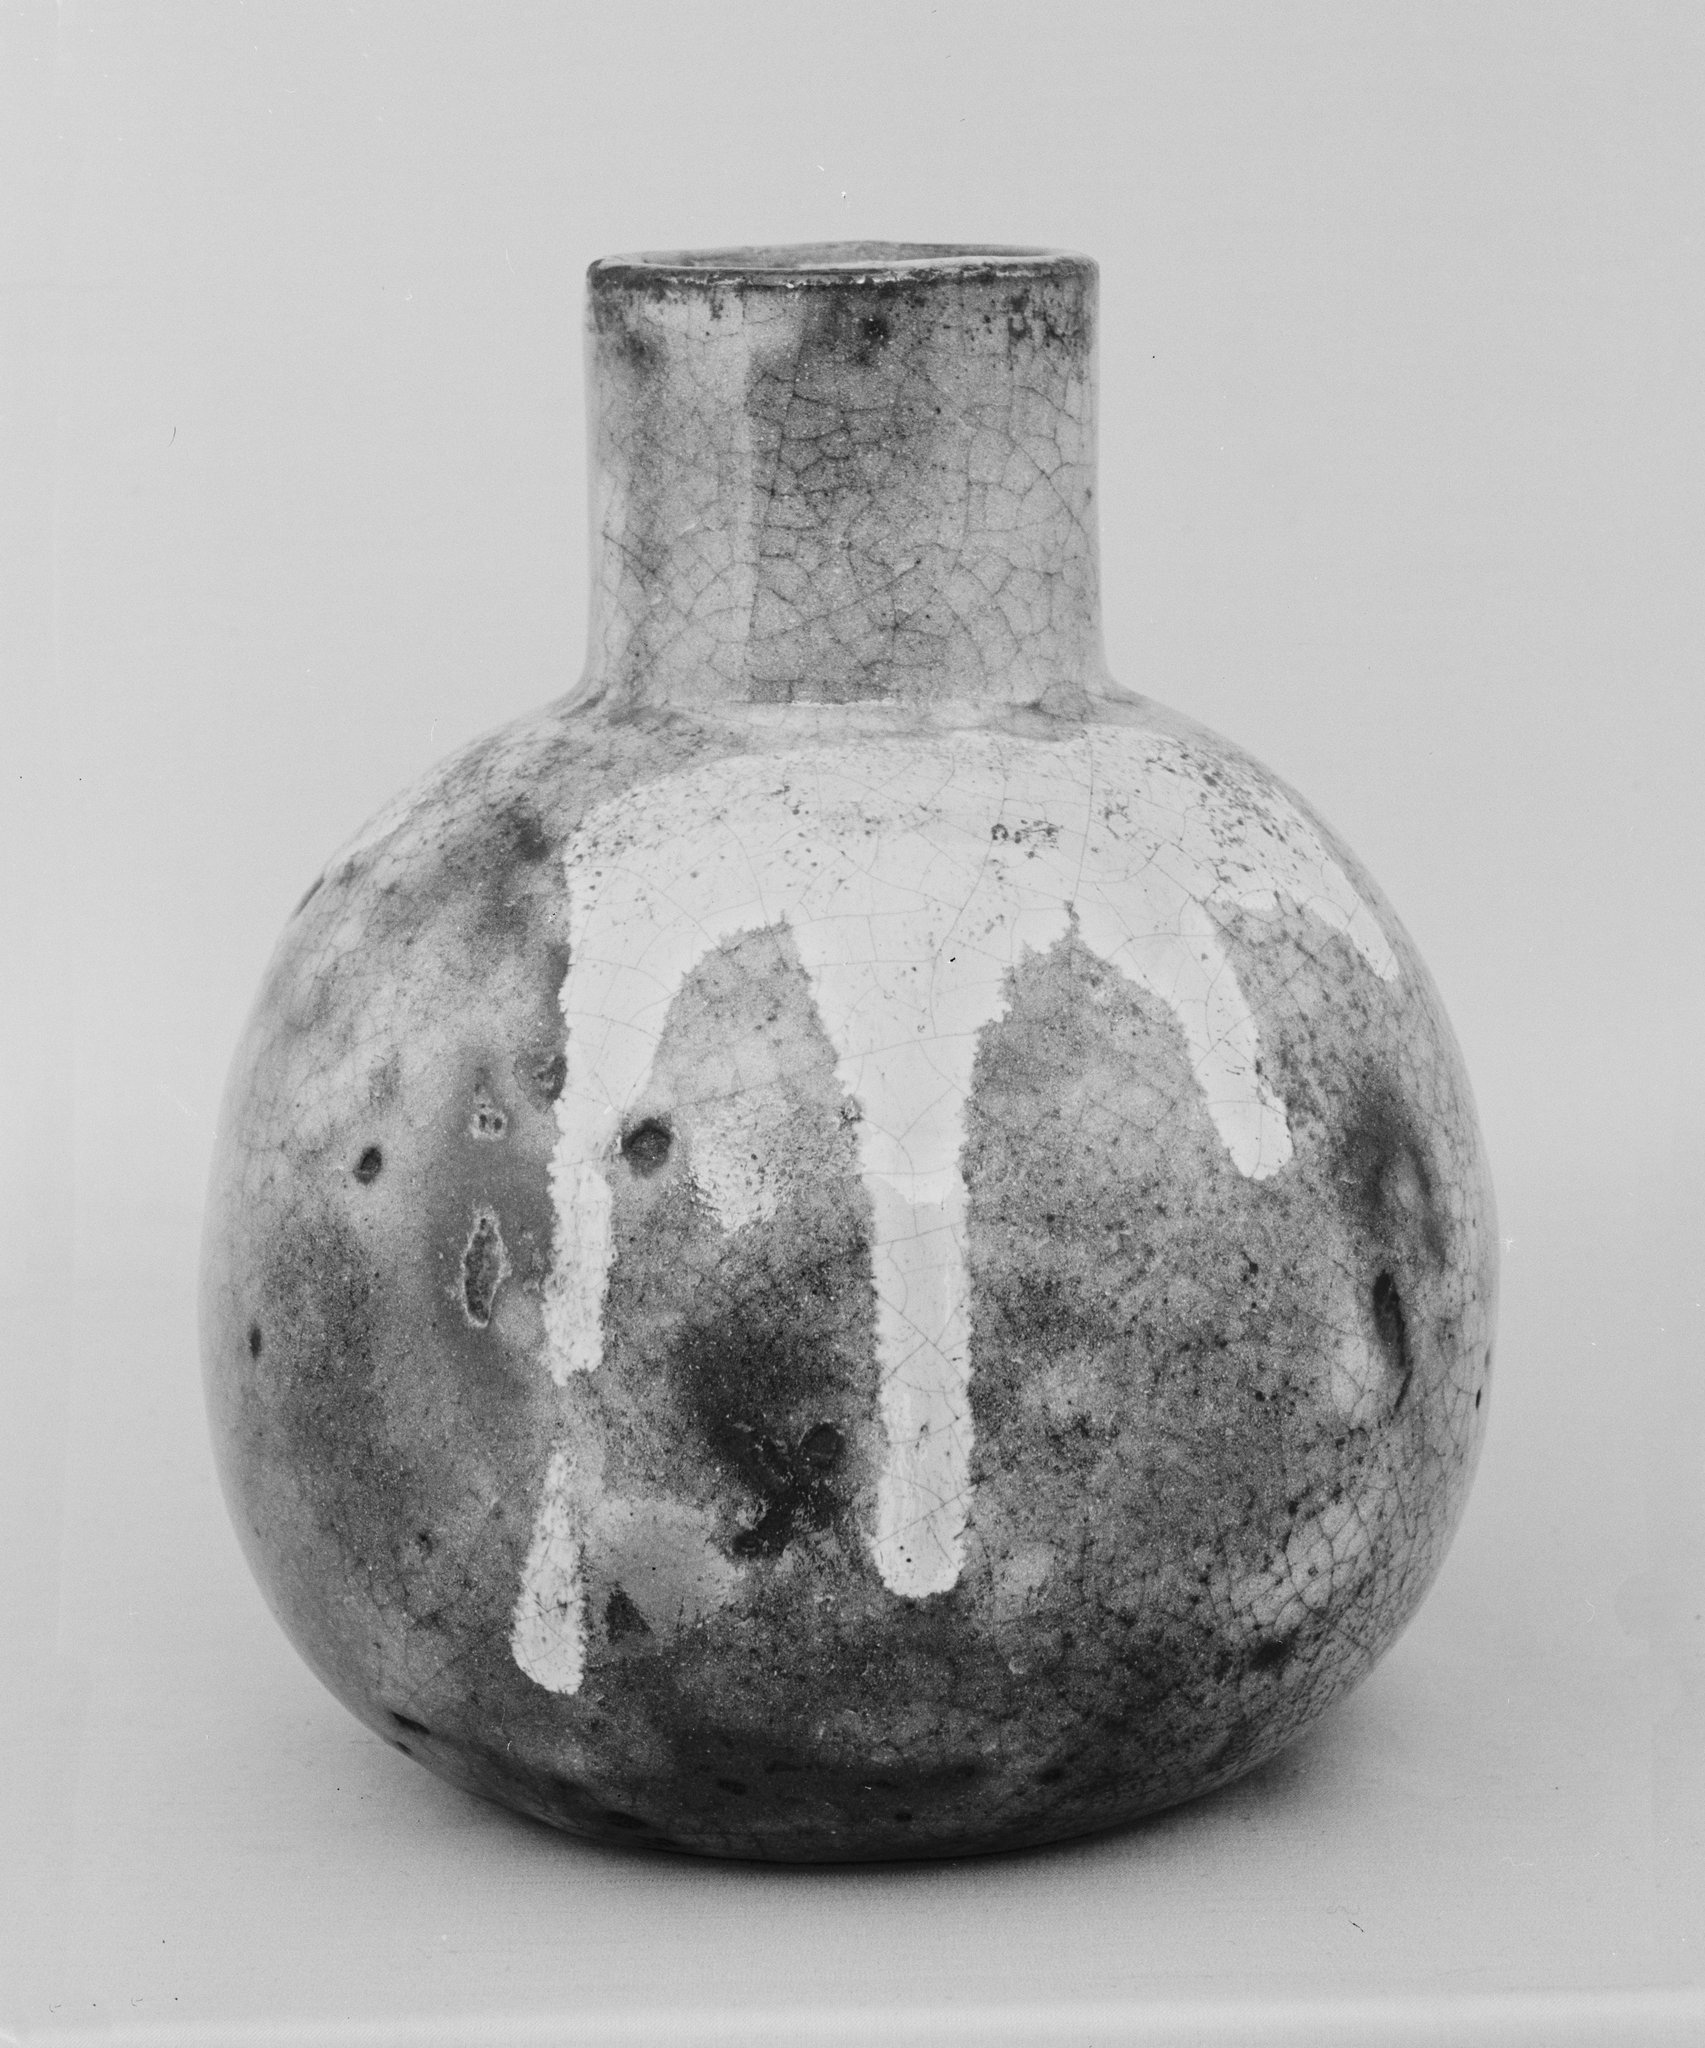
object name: vase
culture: japanese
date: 1801-1900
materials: clay, glaze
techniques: overglaze